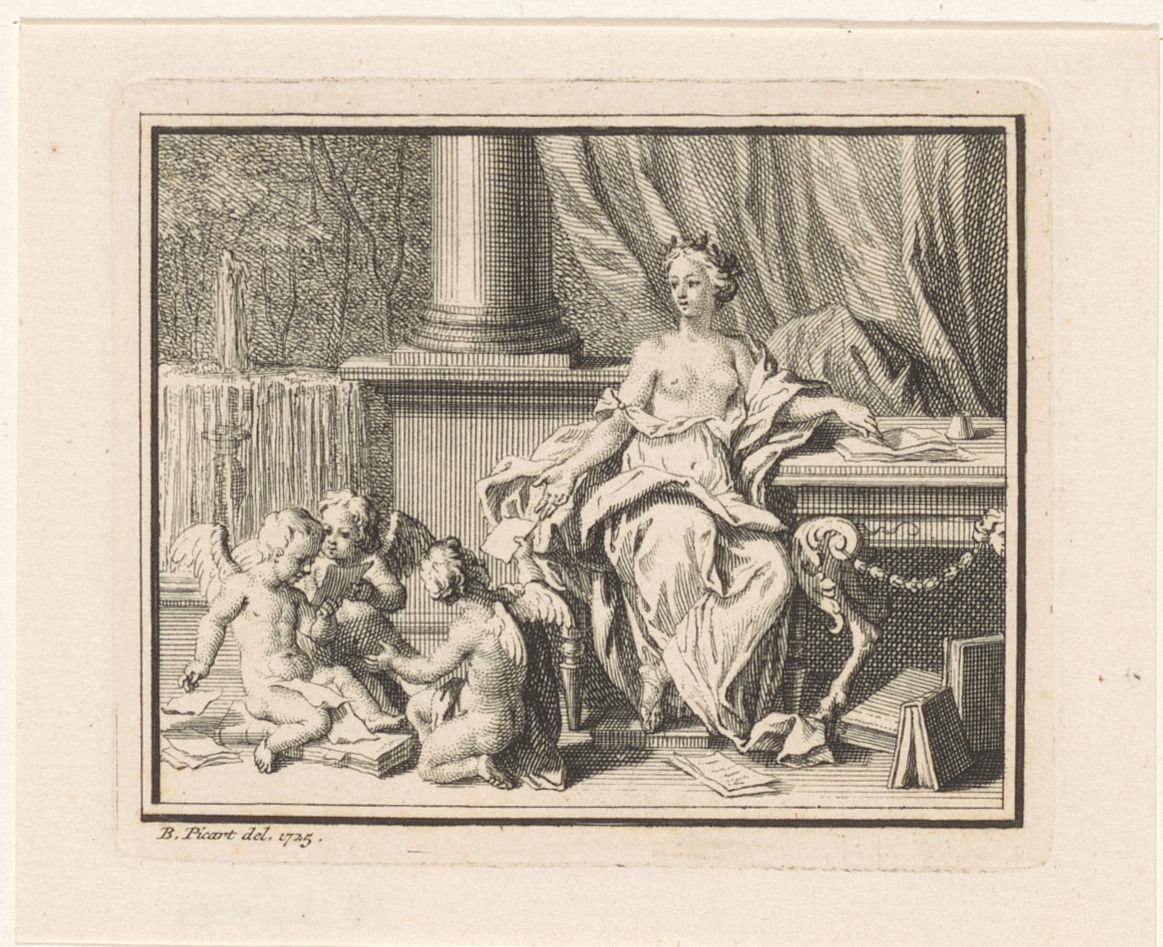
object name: print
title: Clio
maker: bernard picart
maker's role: draughtsman, print maker, publisher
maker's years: 1673-1733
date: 1725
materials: paper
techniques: engraving, etching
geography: amsterdam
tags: clio (one of the muses); 'clio' (ripa)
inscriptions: collector's mark: Lugt 2228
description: De zittende Clio, de muze van de geschiedenis, onderwijst enkele putti die boeken bestuderen.